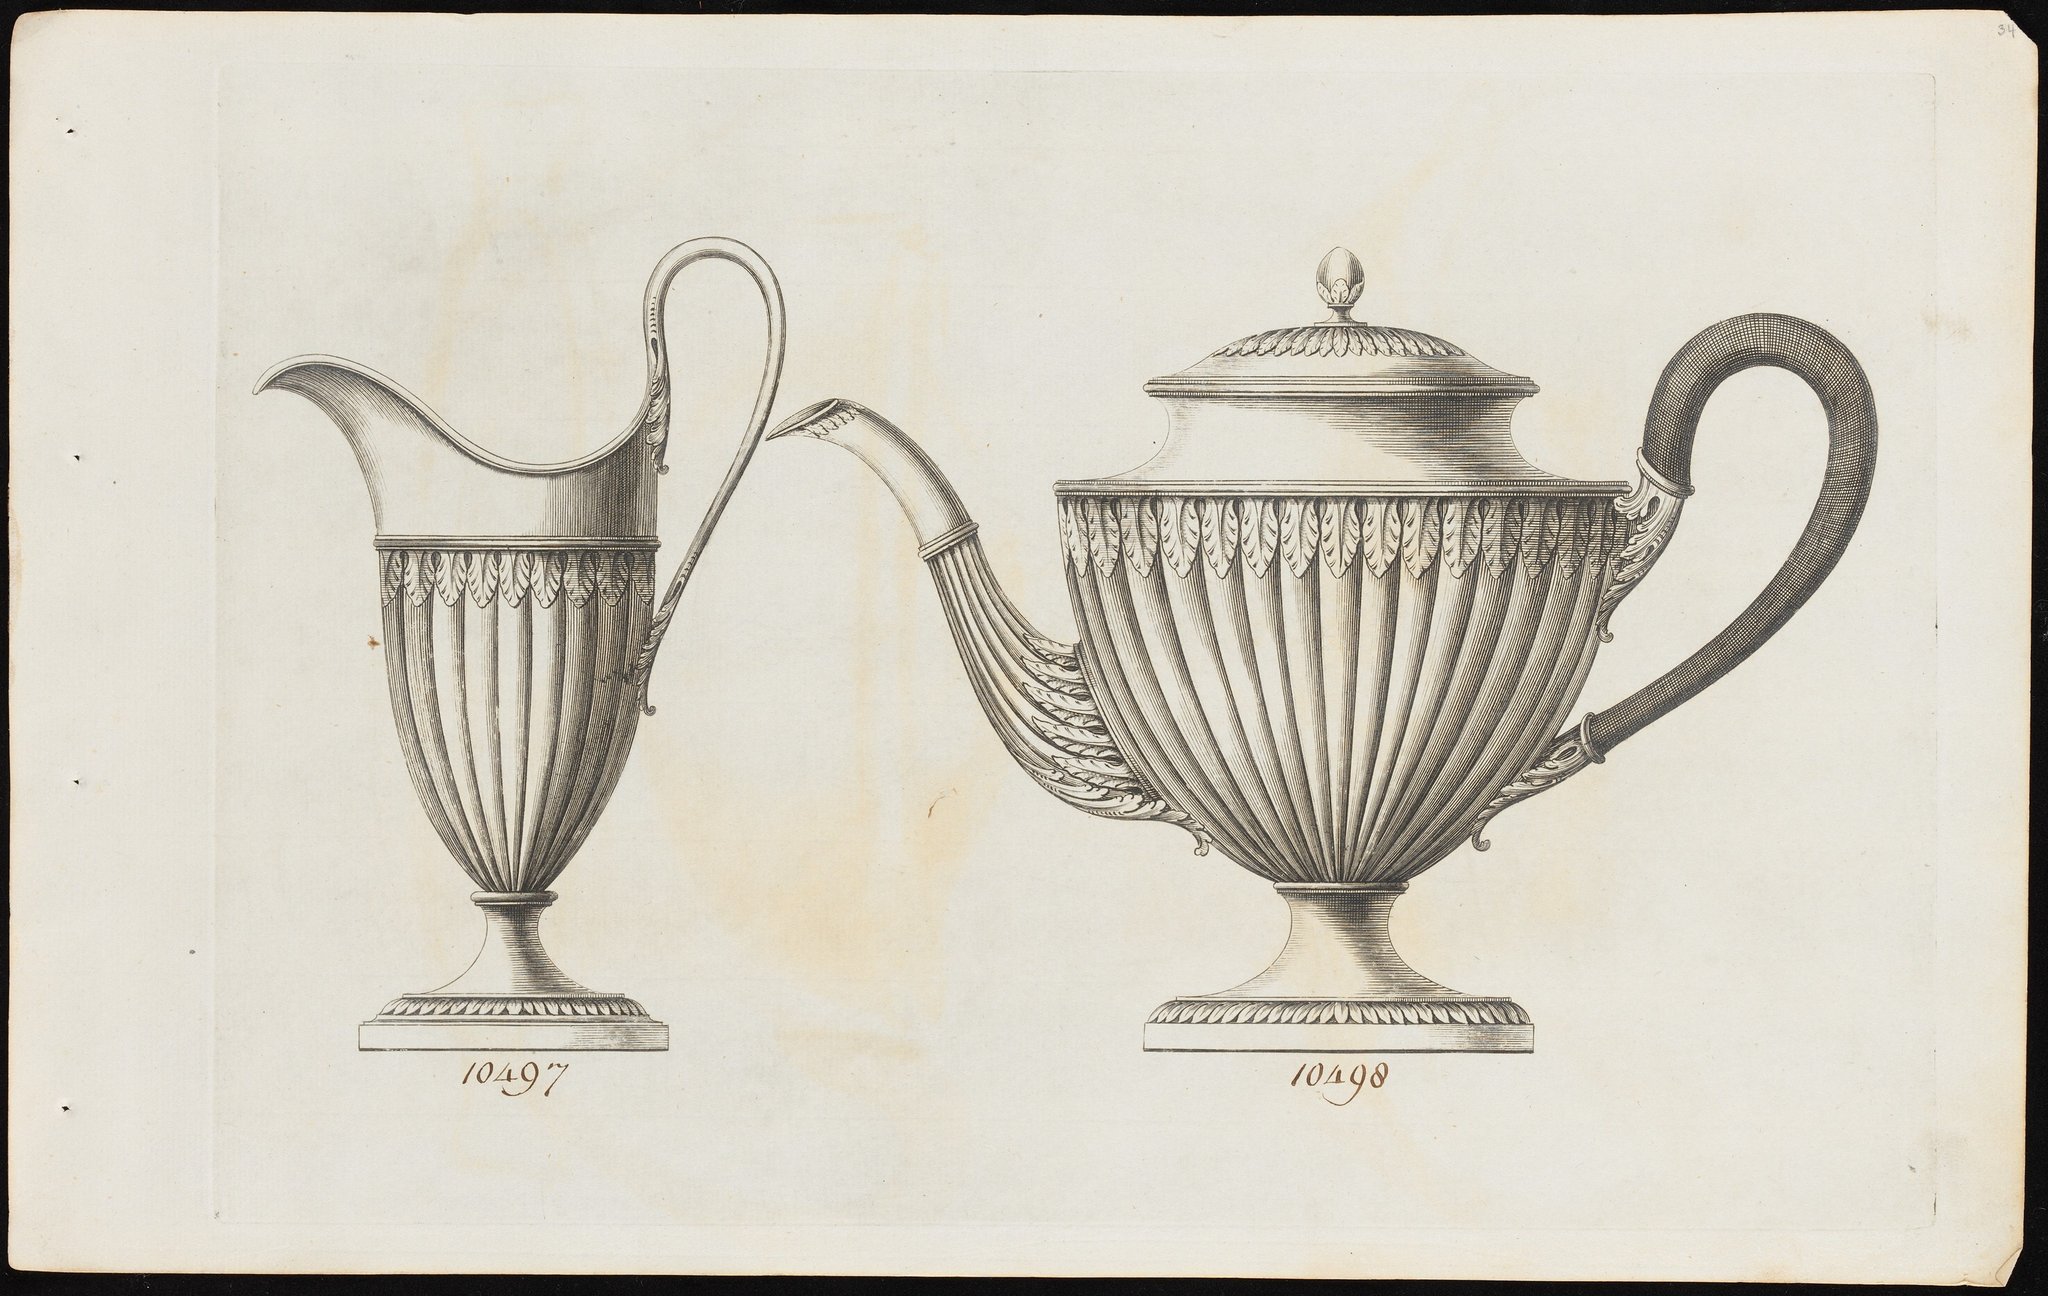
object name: print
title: Creamer and Teapot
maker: matthew boulton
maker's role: artist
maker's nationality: british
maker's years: 1728-1809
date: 1790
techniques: etching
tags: teapots